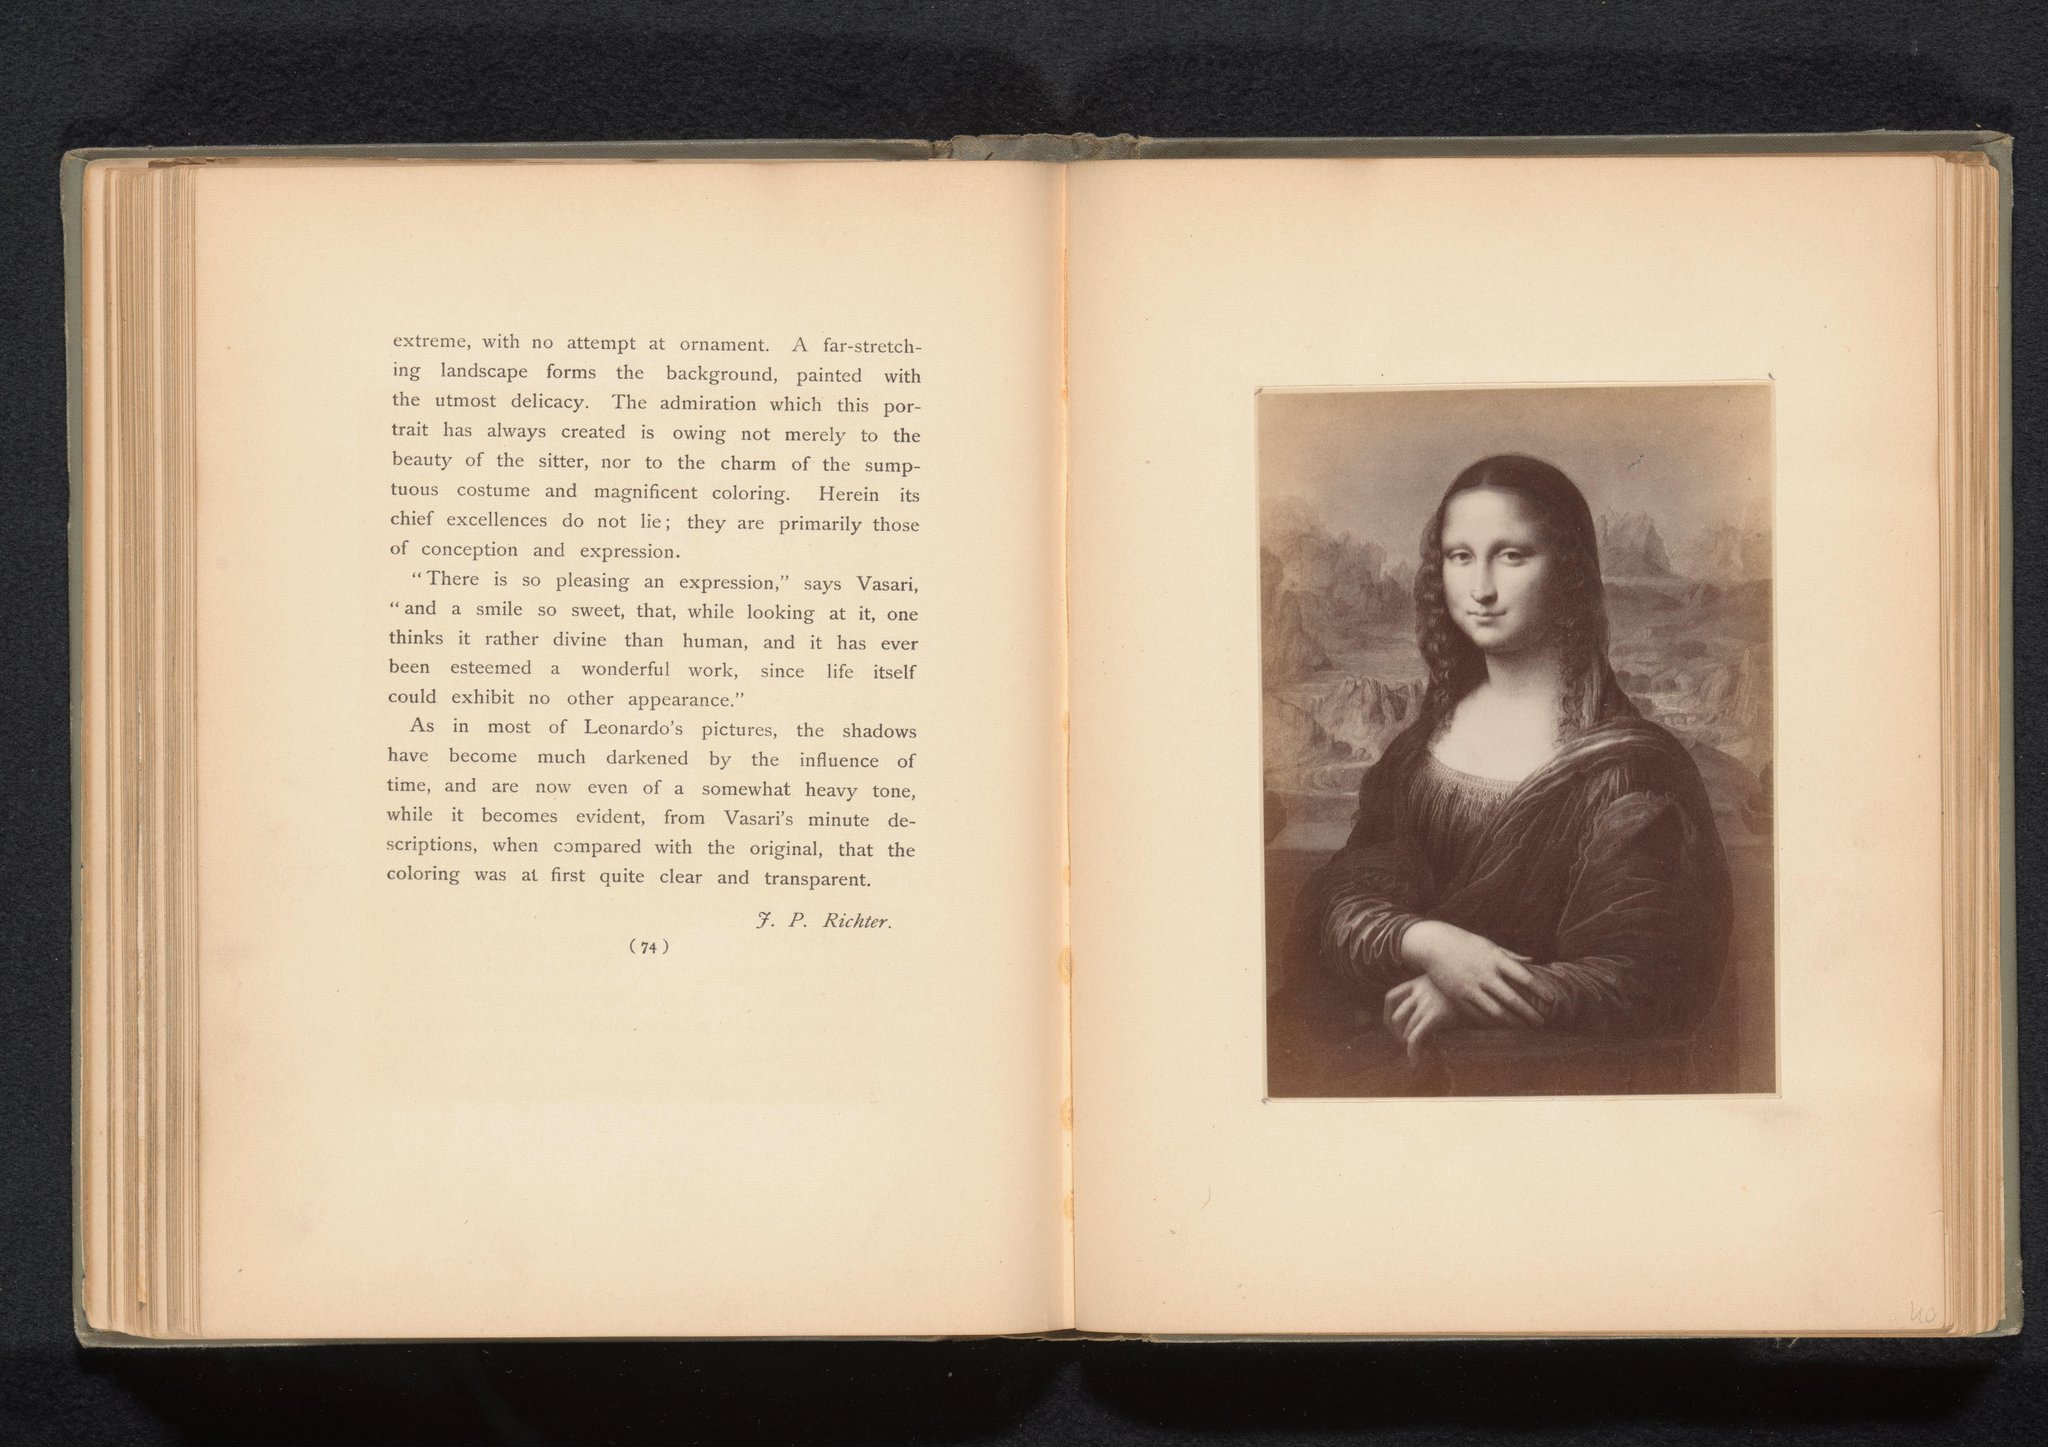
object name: page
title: Fotoreproductie van een prent naar het schilderij Mona Lisa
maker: Anonymous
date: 1882-1887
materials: photographic support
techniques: albumen print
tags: adult woman